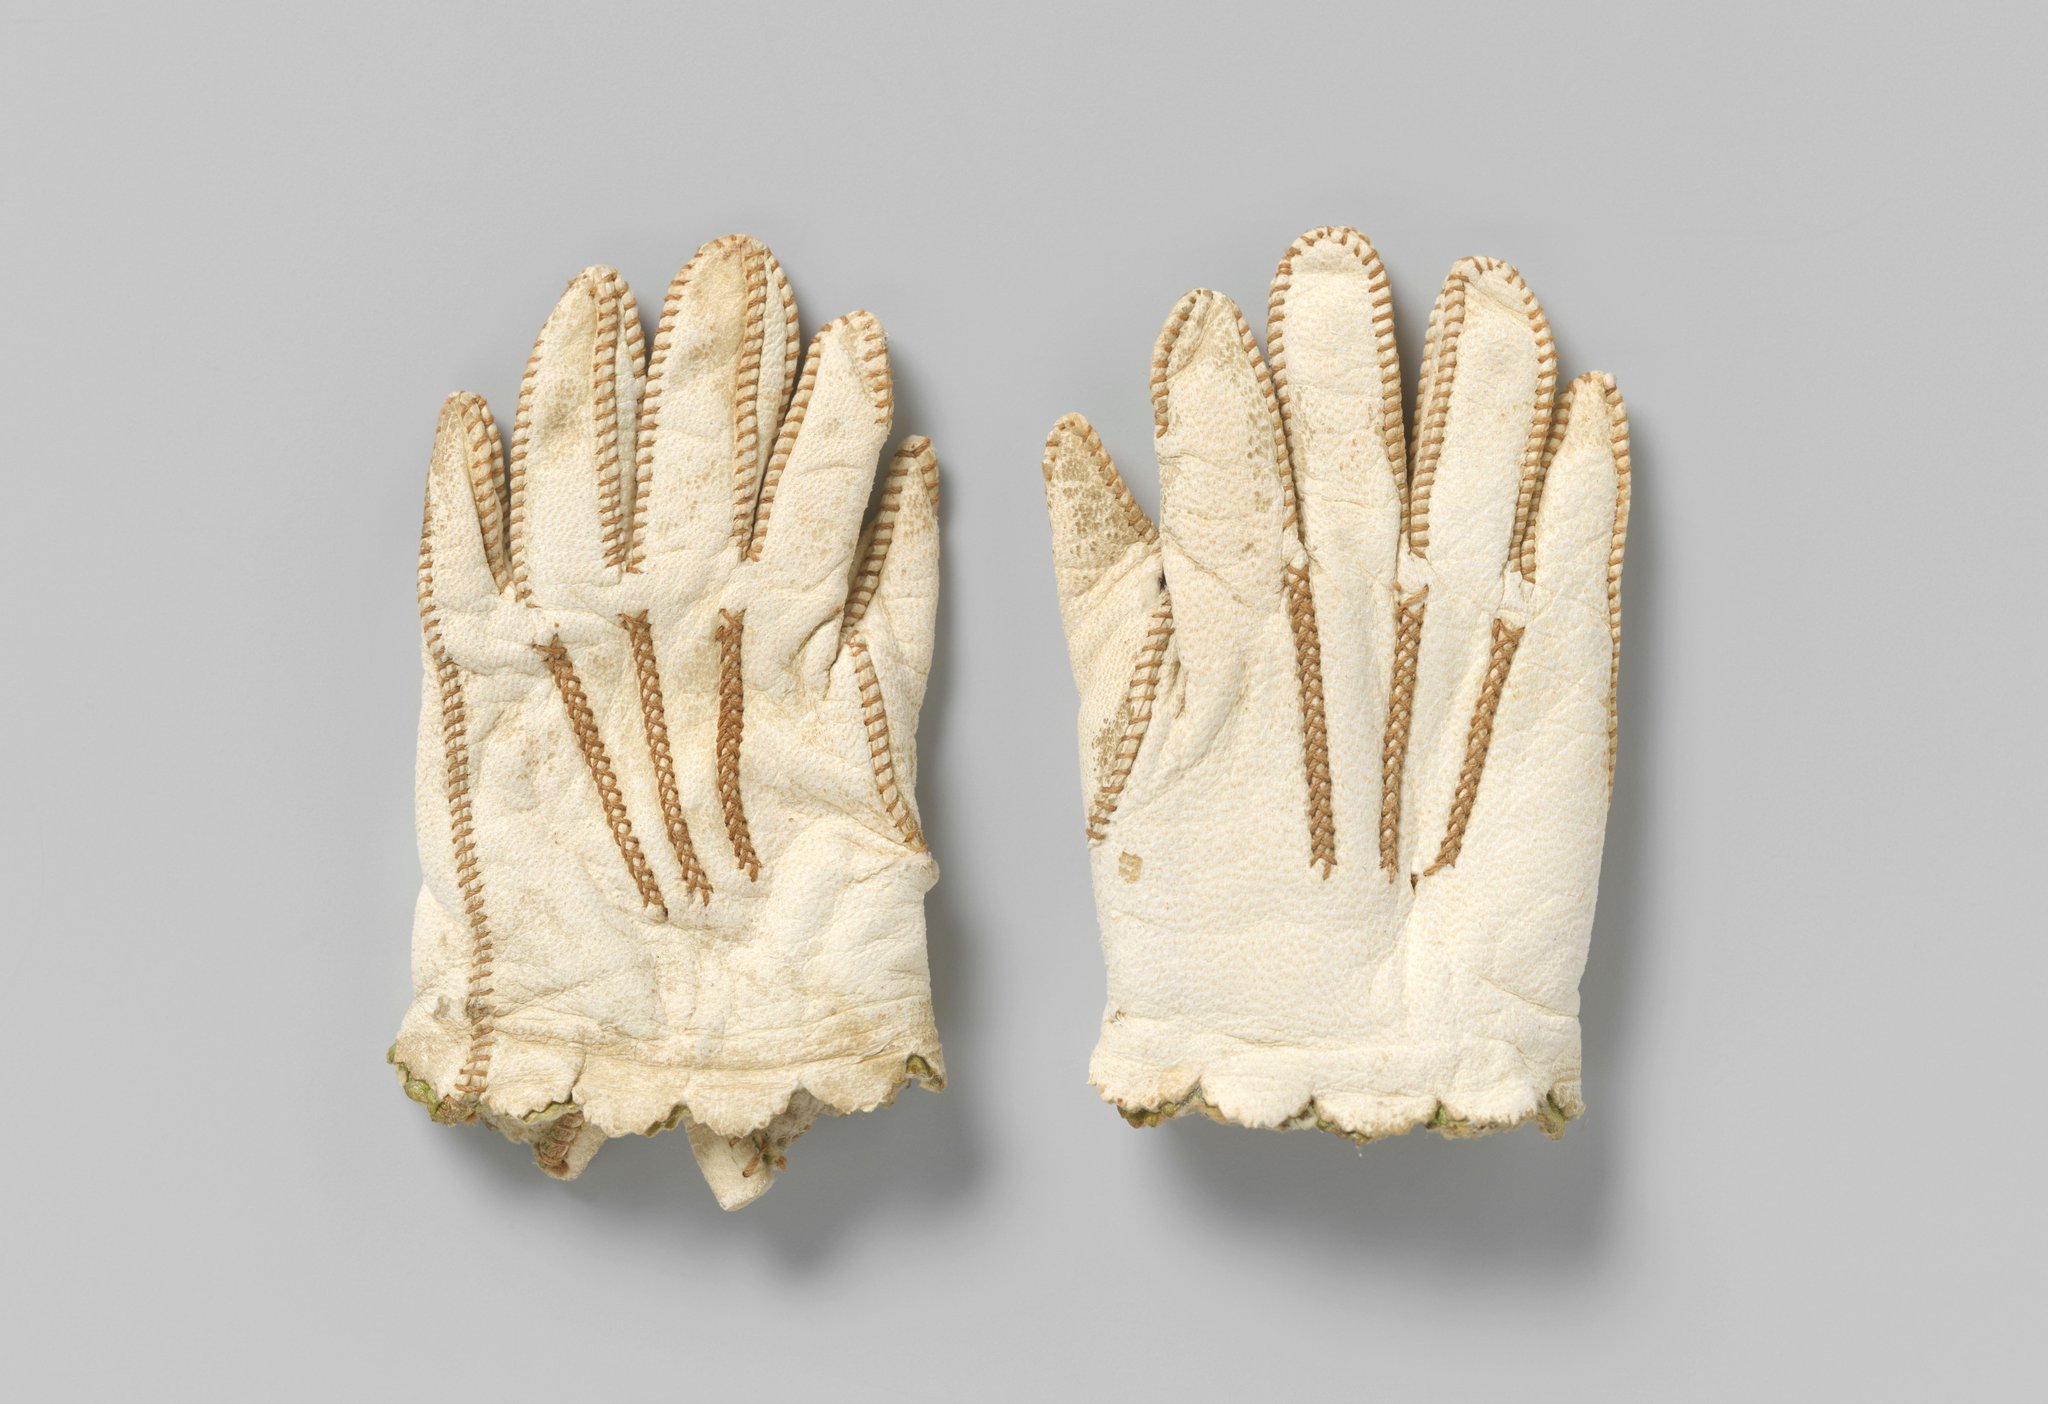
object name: doll's clothing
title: Paar handschoenen van witte glacé, met knoop en geschulpte rand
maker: Anonymous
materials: leather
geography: netherlands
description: Paar handschoenen van witte glacé, met knoop en geschulpte rand.